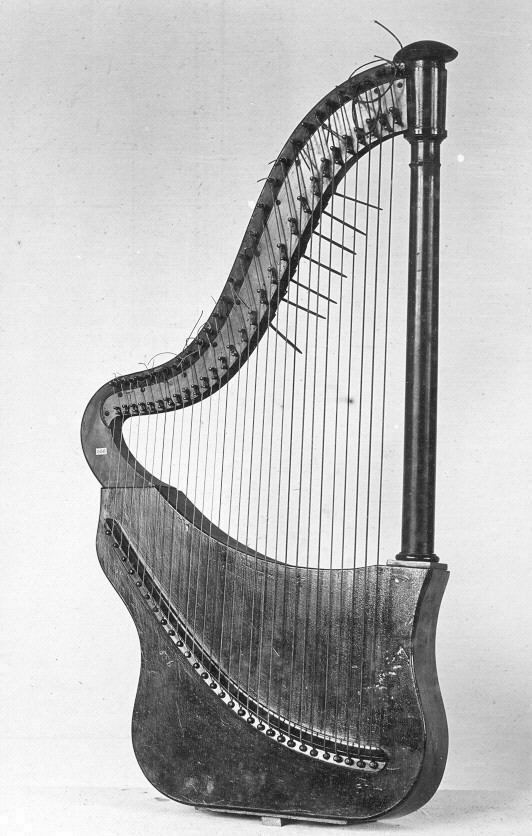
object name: harp lyre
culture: french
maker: pfeiffer & brimmeyr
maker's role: maker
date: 1801-1900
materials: wood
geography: france